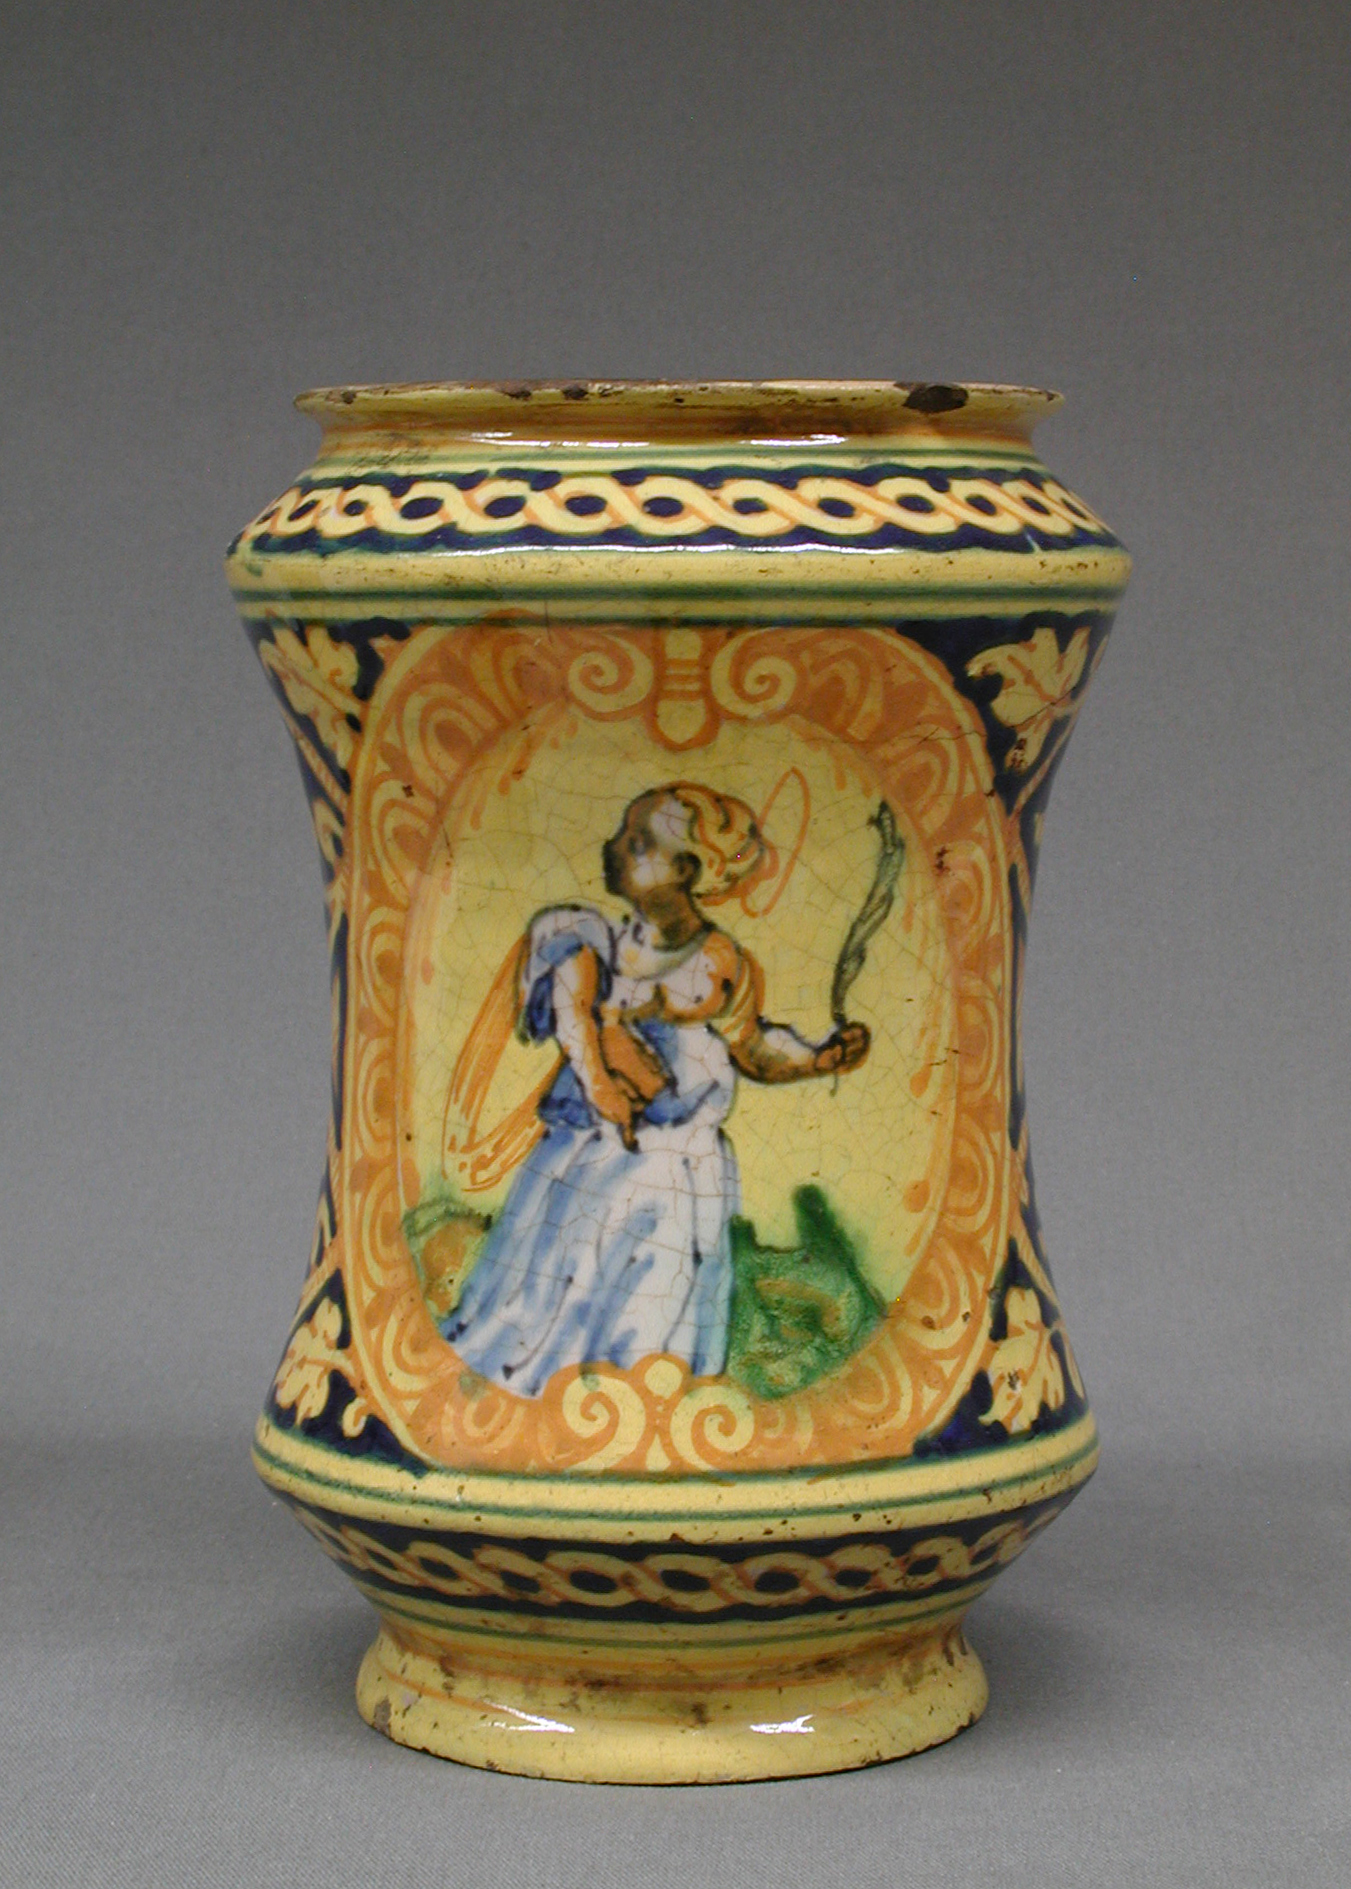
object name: albarello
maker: vincenzo di marco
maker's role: maker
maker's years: 1525-1625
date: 1551-1600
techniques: maiolica, glazing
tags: human figures